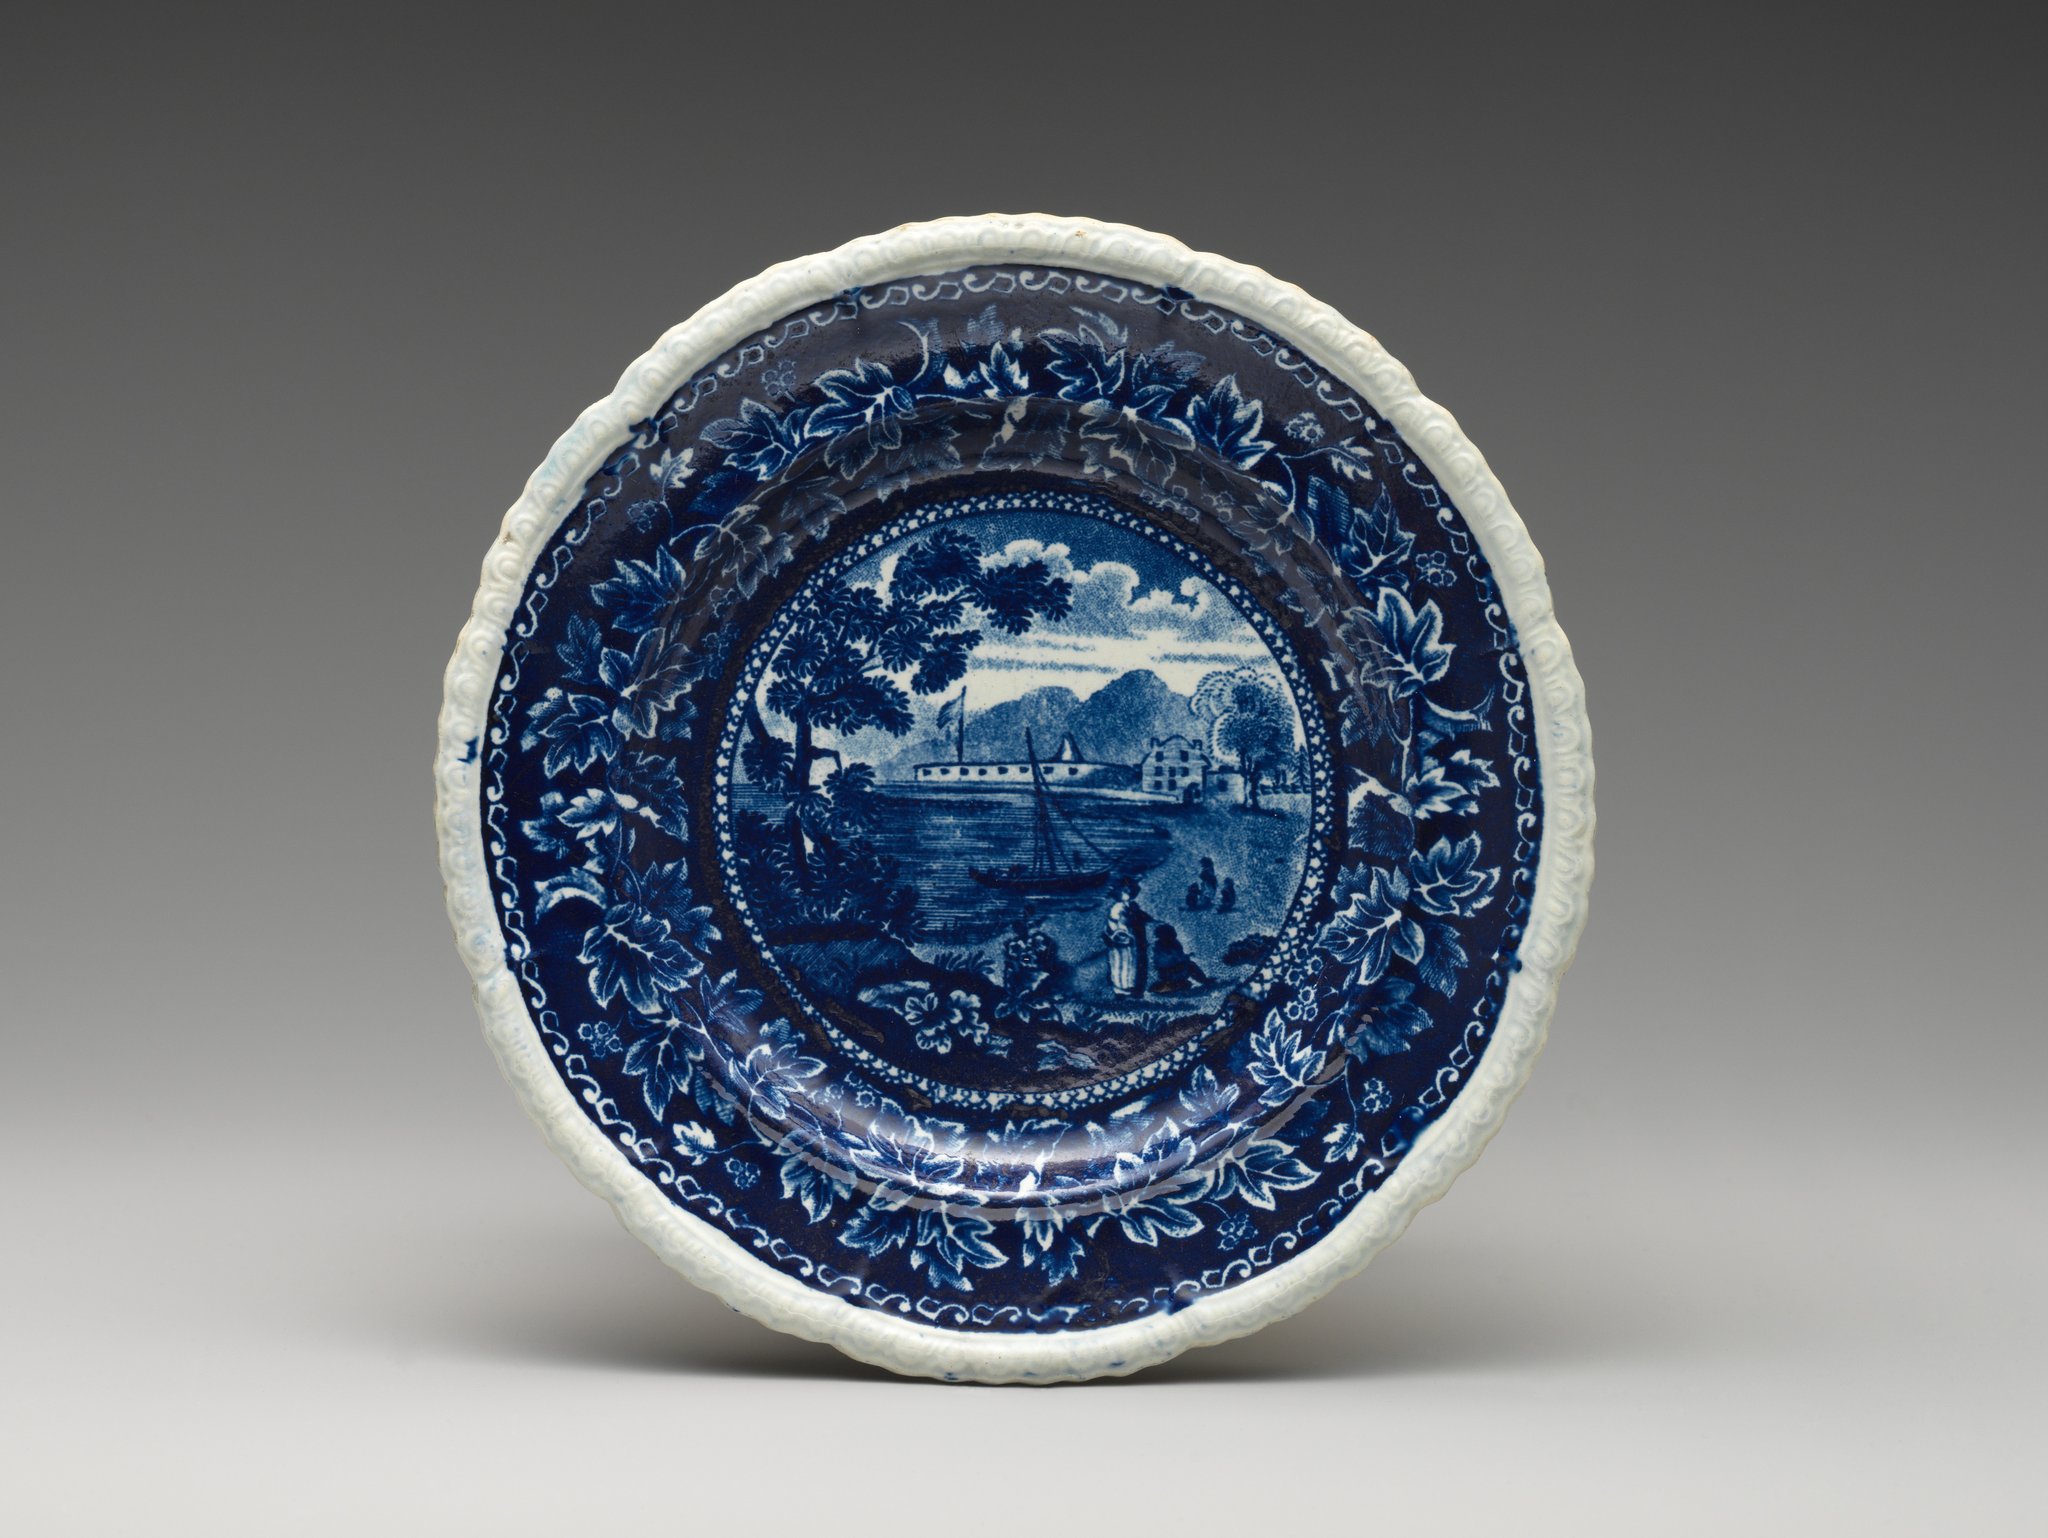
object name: plate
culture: british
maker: ralph stevenson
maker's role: maker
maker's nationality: british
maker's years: 1805-1832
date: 1810-1830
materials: earthenware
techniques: transfer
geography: england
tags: fortification